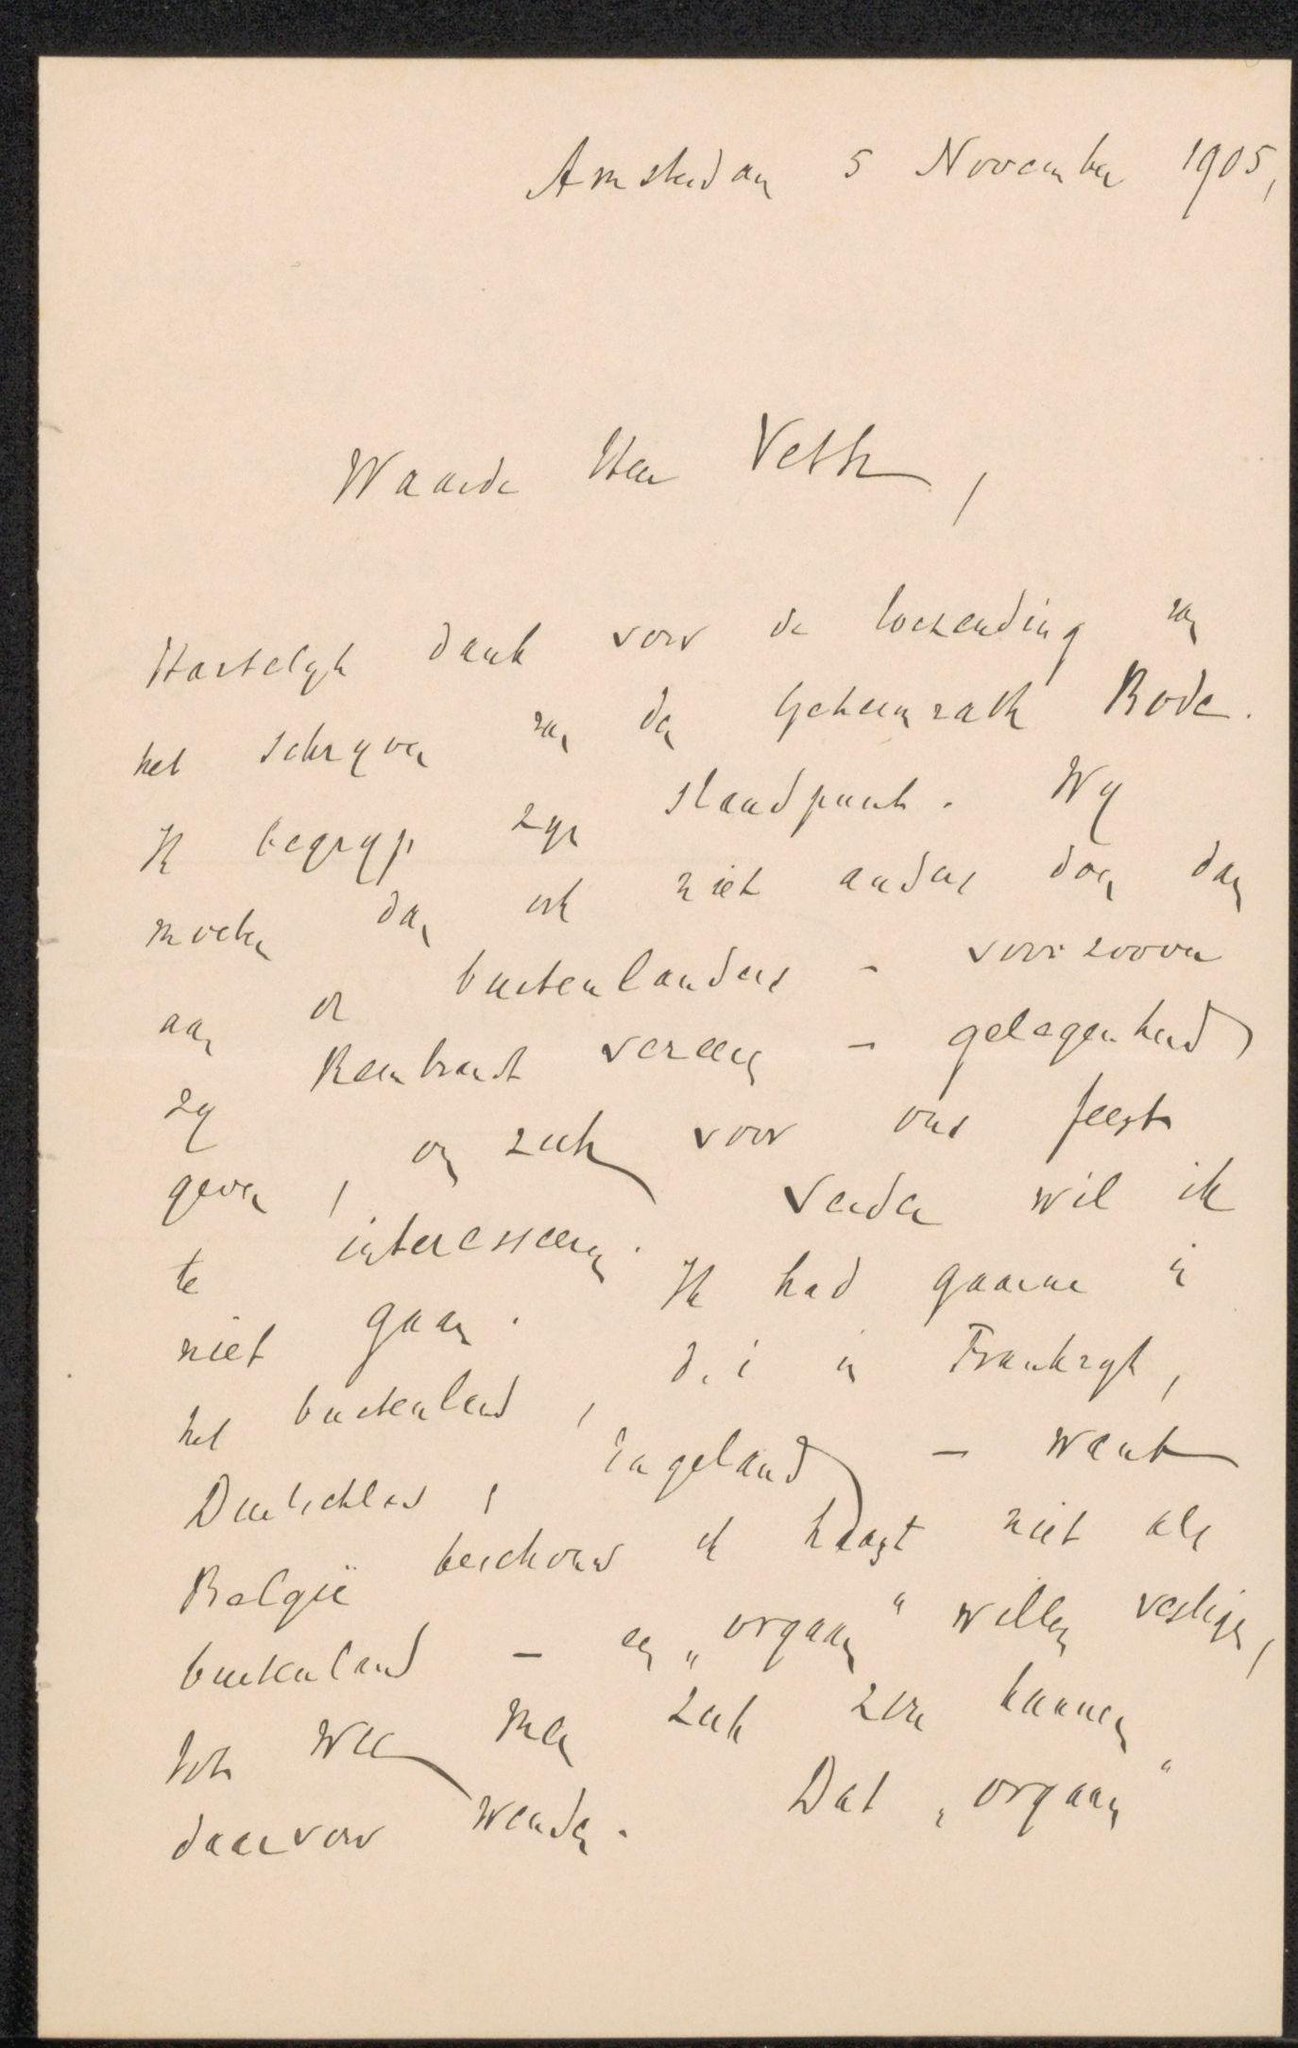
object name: letter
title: Brief aan Jan Veth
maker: hendrick peter godfried quack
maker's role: econoom, geschiedschrijver, hoogleraar, jurist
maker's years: 1834-1917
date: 1905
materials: ink, paper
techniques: pen, writing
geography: amsterdam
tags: painter, léon bonnat, dordrecht, print maker, draughtsman, designer, jan veth, leiden, rembrandt van rijn, lodewijk van deyssel, alphons diepenbrock, berlin, wilhelm von bode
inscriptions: collector's mark: ‘RPK’, watermark